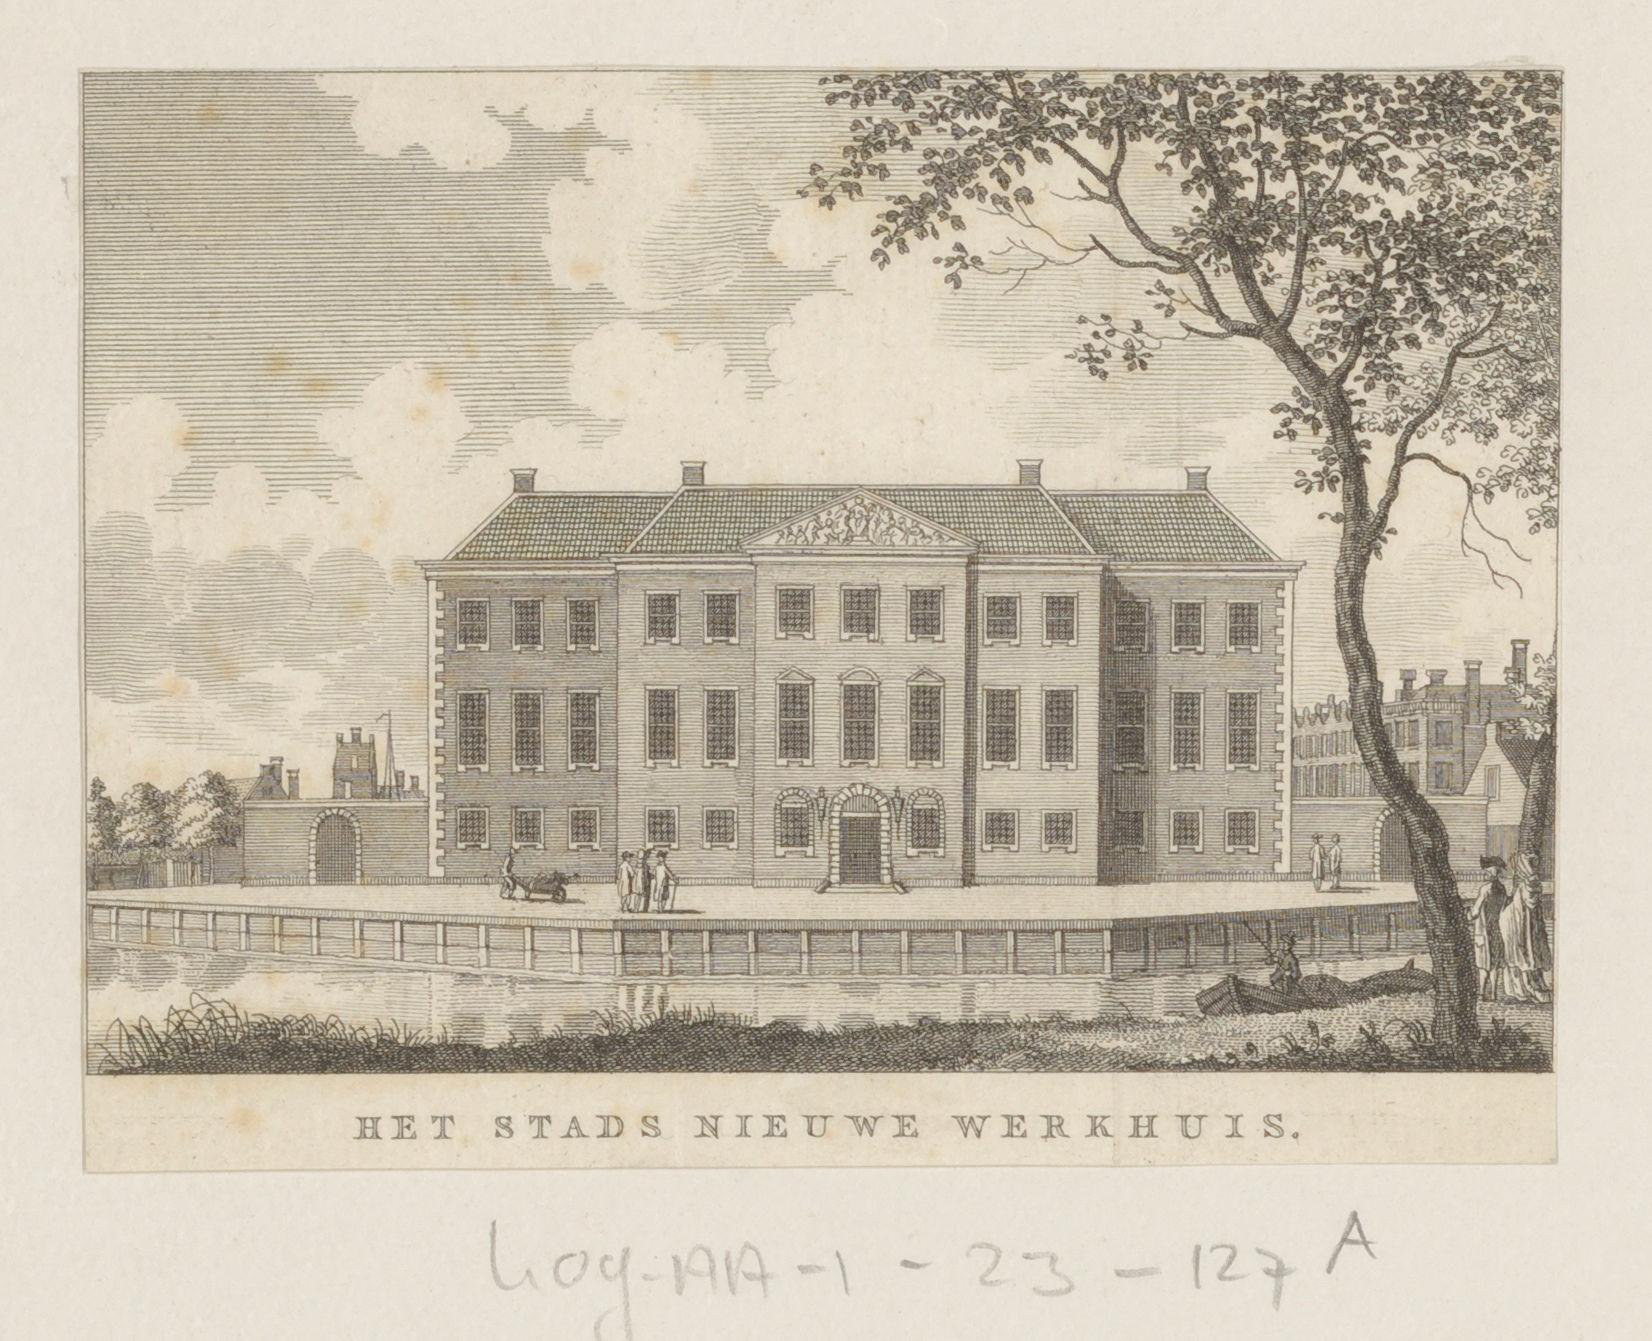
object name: print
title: Gezicht op het Nieuwe Werkhuis te Amsterdam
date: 1789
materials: paper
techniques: etching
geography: amsterdam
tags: prison, jail, canals, waters (in city), workhouse, penal camp, penitentiary, chain gang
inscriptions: collector's mark: Lugt 1641b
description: Prent mogelijk uit: Amsteldam en zyne geschiedenissen, in 't kort. Amsterdam: Johannes Allart, 1789, dl. 3.